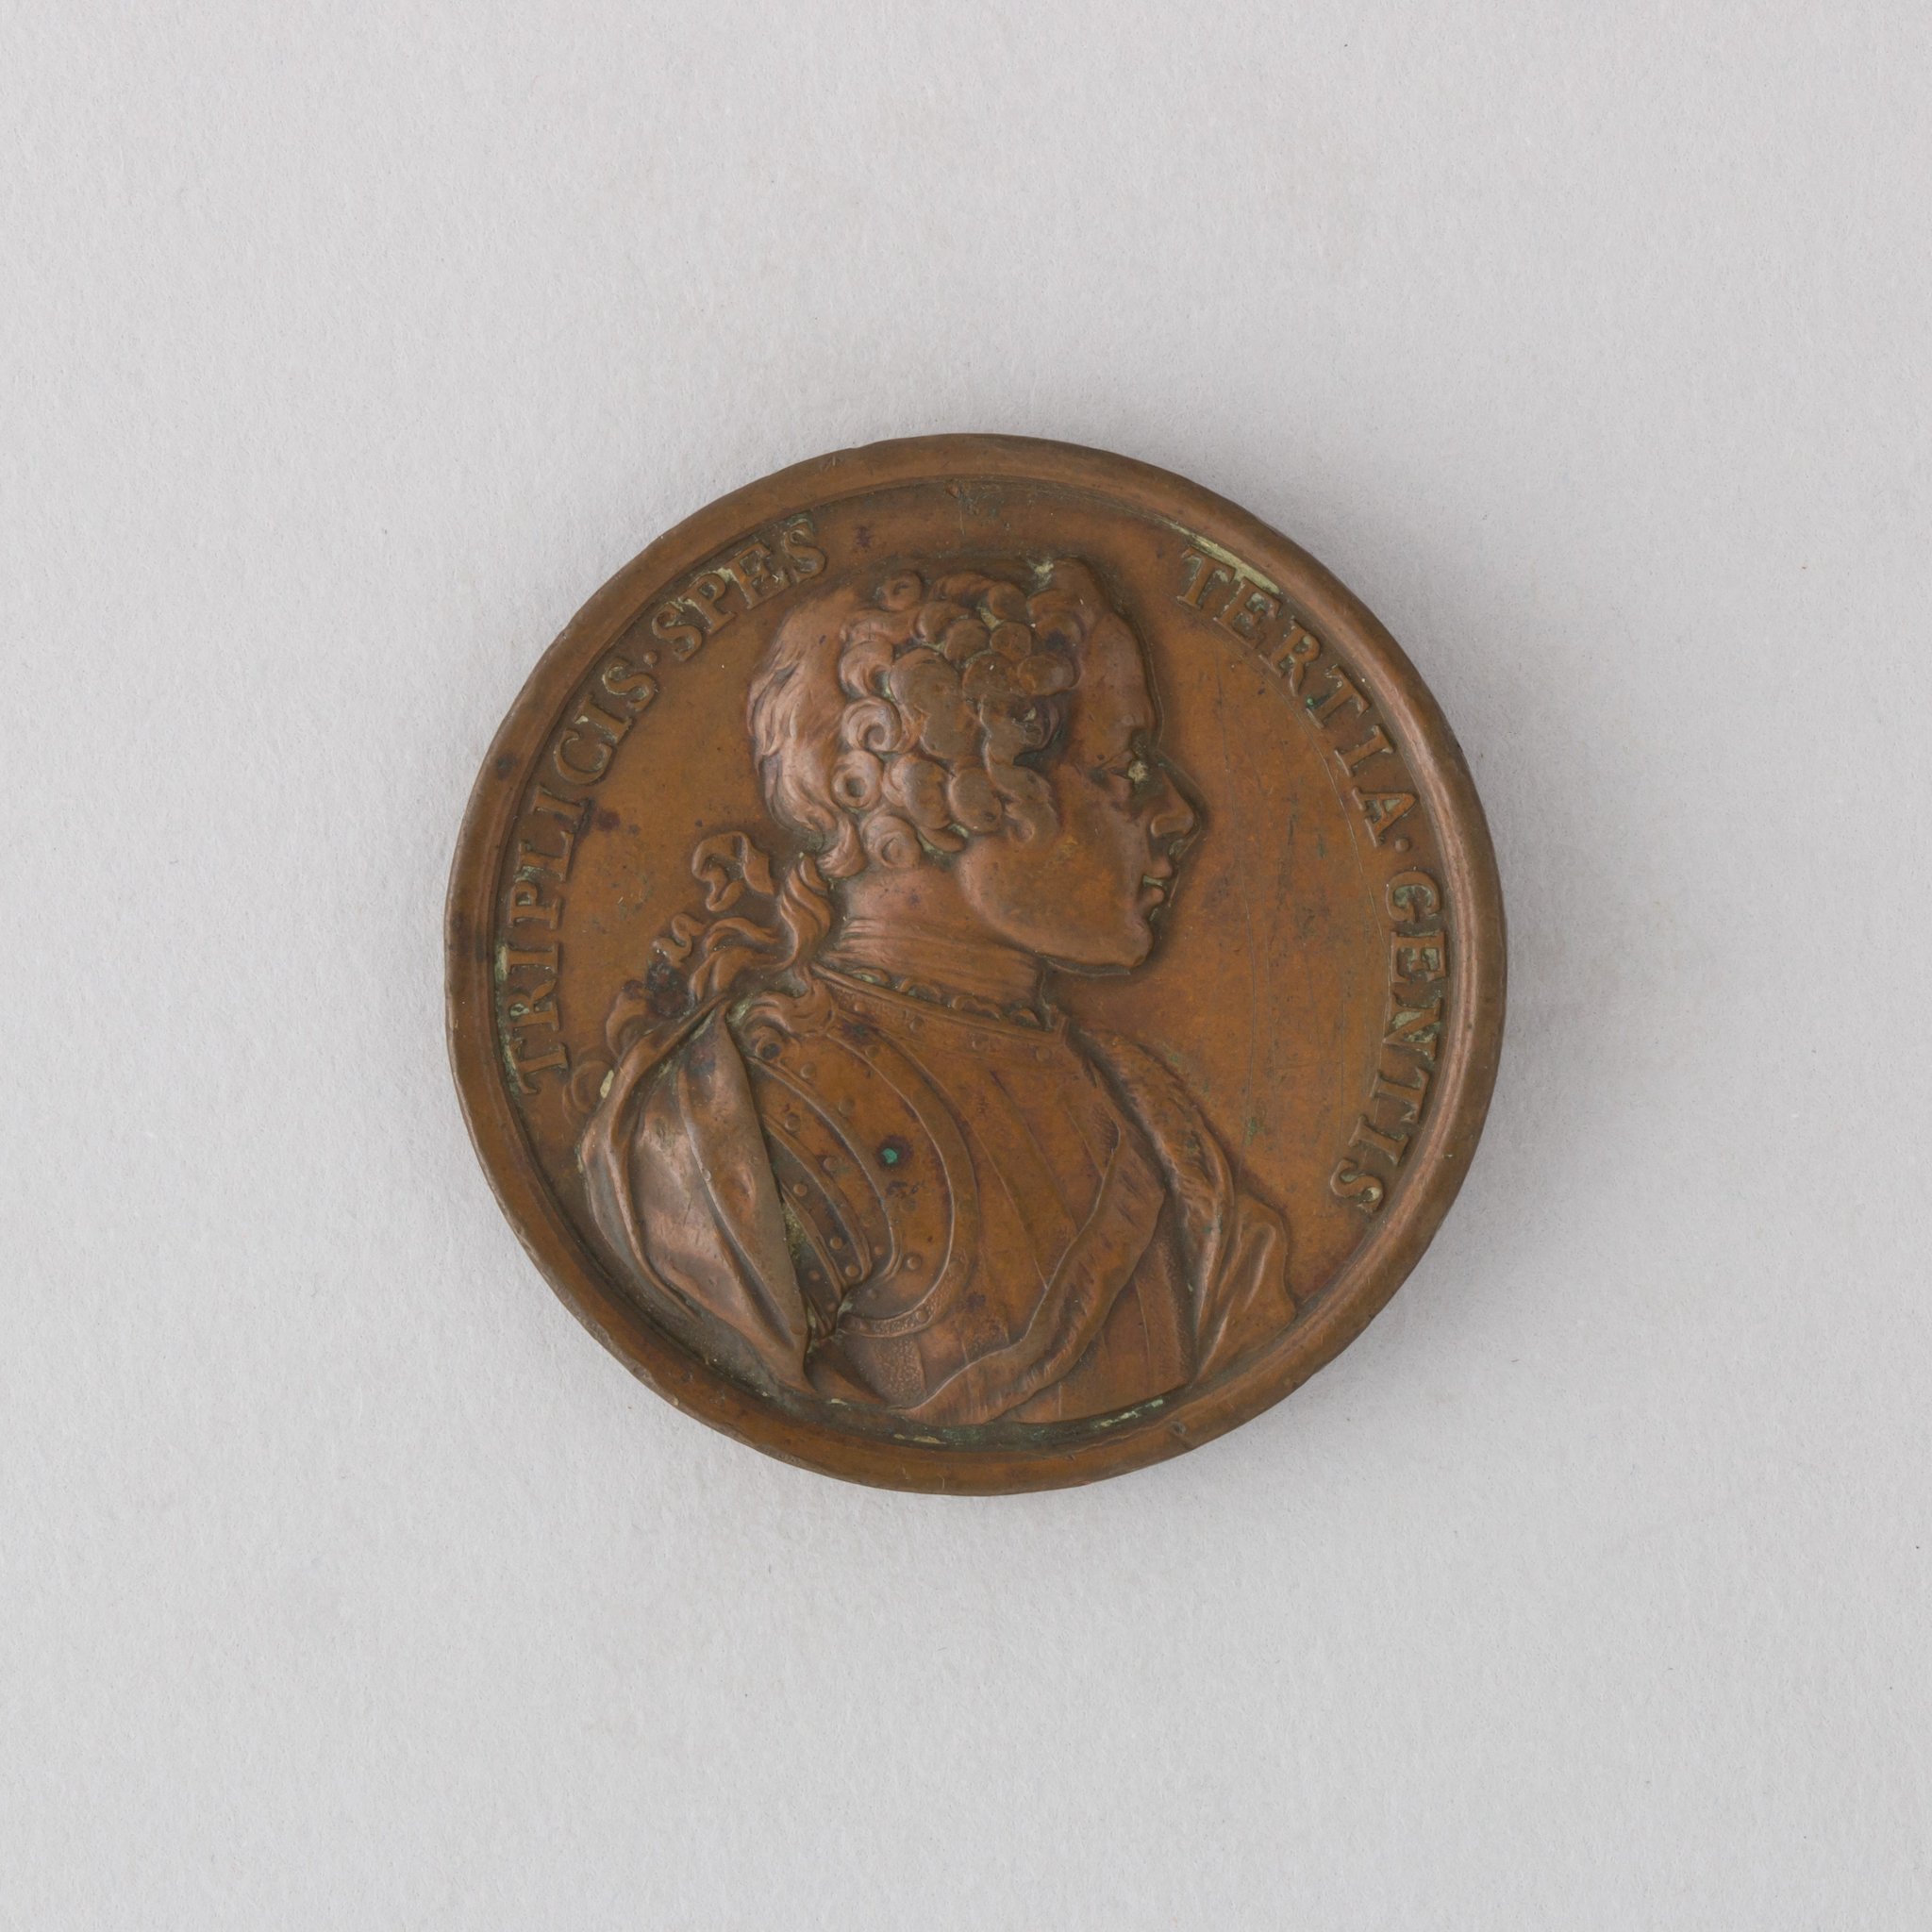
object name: medal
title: Medal Showing Prince Charles and Prince Henry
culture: scottish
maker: ottone hamerani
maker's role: artist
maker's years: 1694-1768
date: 1729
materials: bronze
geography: scotland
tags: princes,profiles